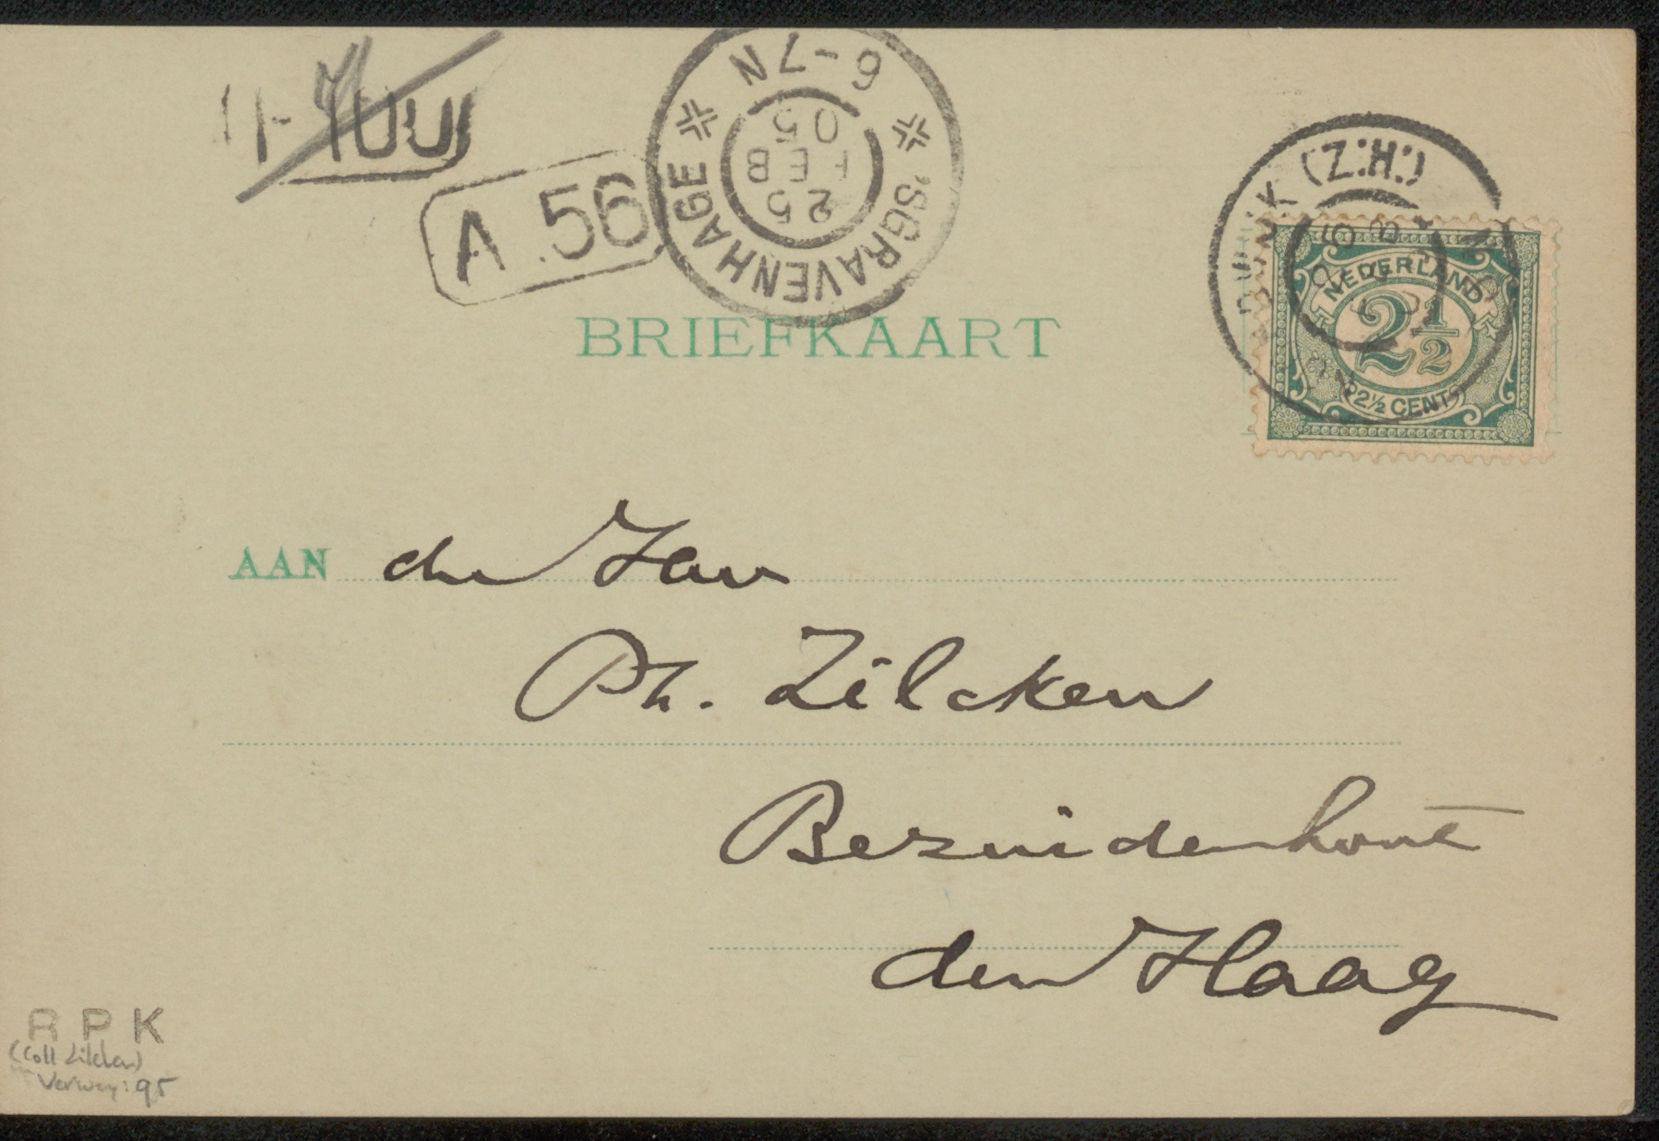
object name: postcard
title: Briefkaart aan Philip Zilcken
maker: albert verwey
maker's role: criticus, dichter, essayist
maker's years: 1865-1937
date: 1905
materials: cardboard, ink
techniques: pen, writing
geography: noordwijk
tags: delft, albert plasschaert, the hague, draughtsman, philip zilcken, diseases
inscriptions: collector's mark: ‘RPK’